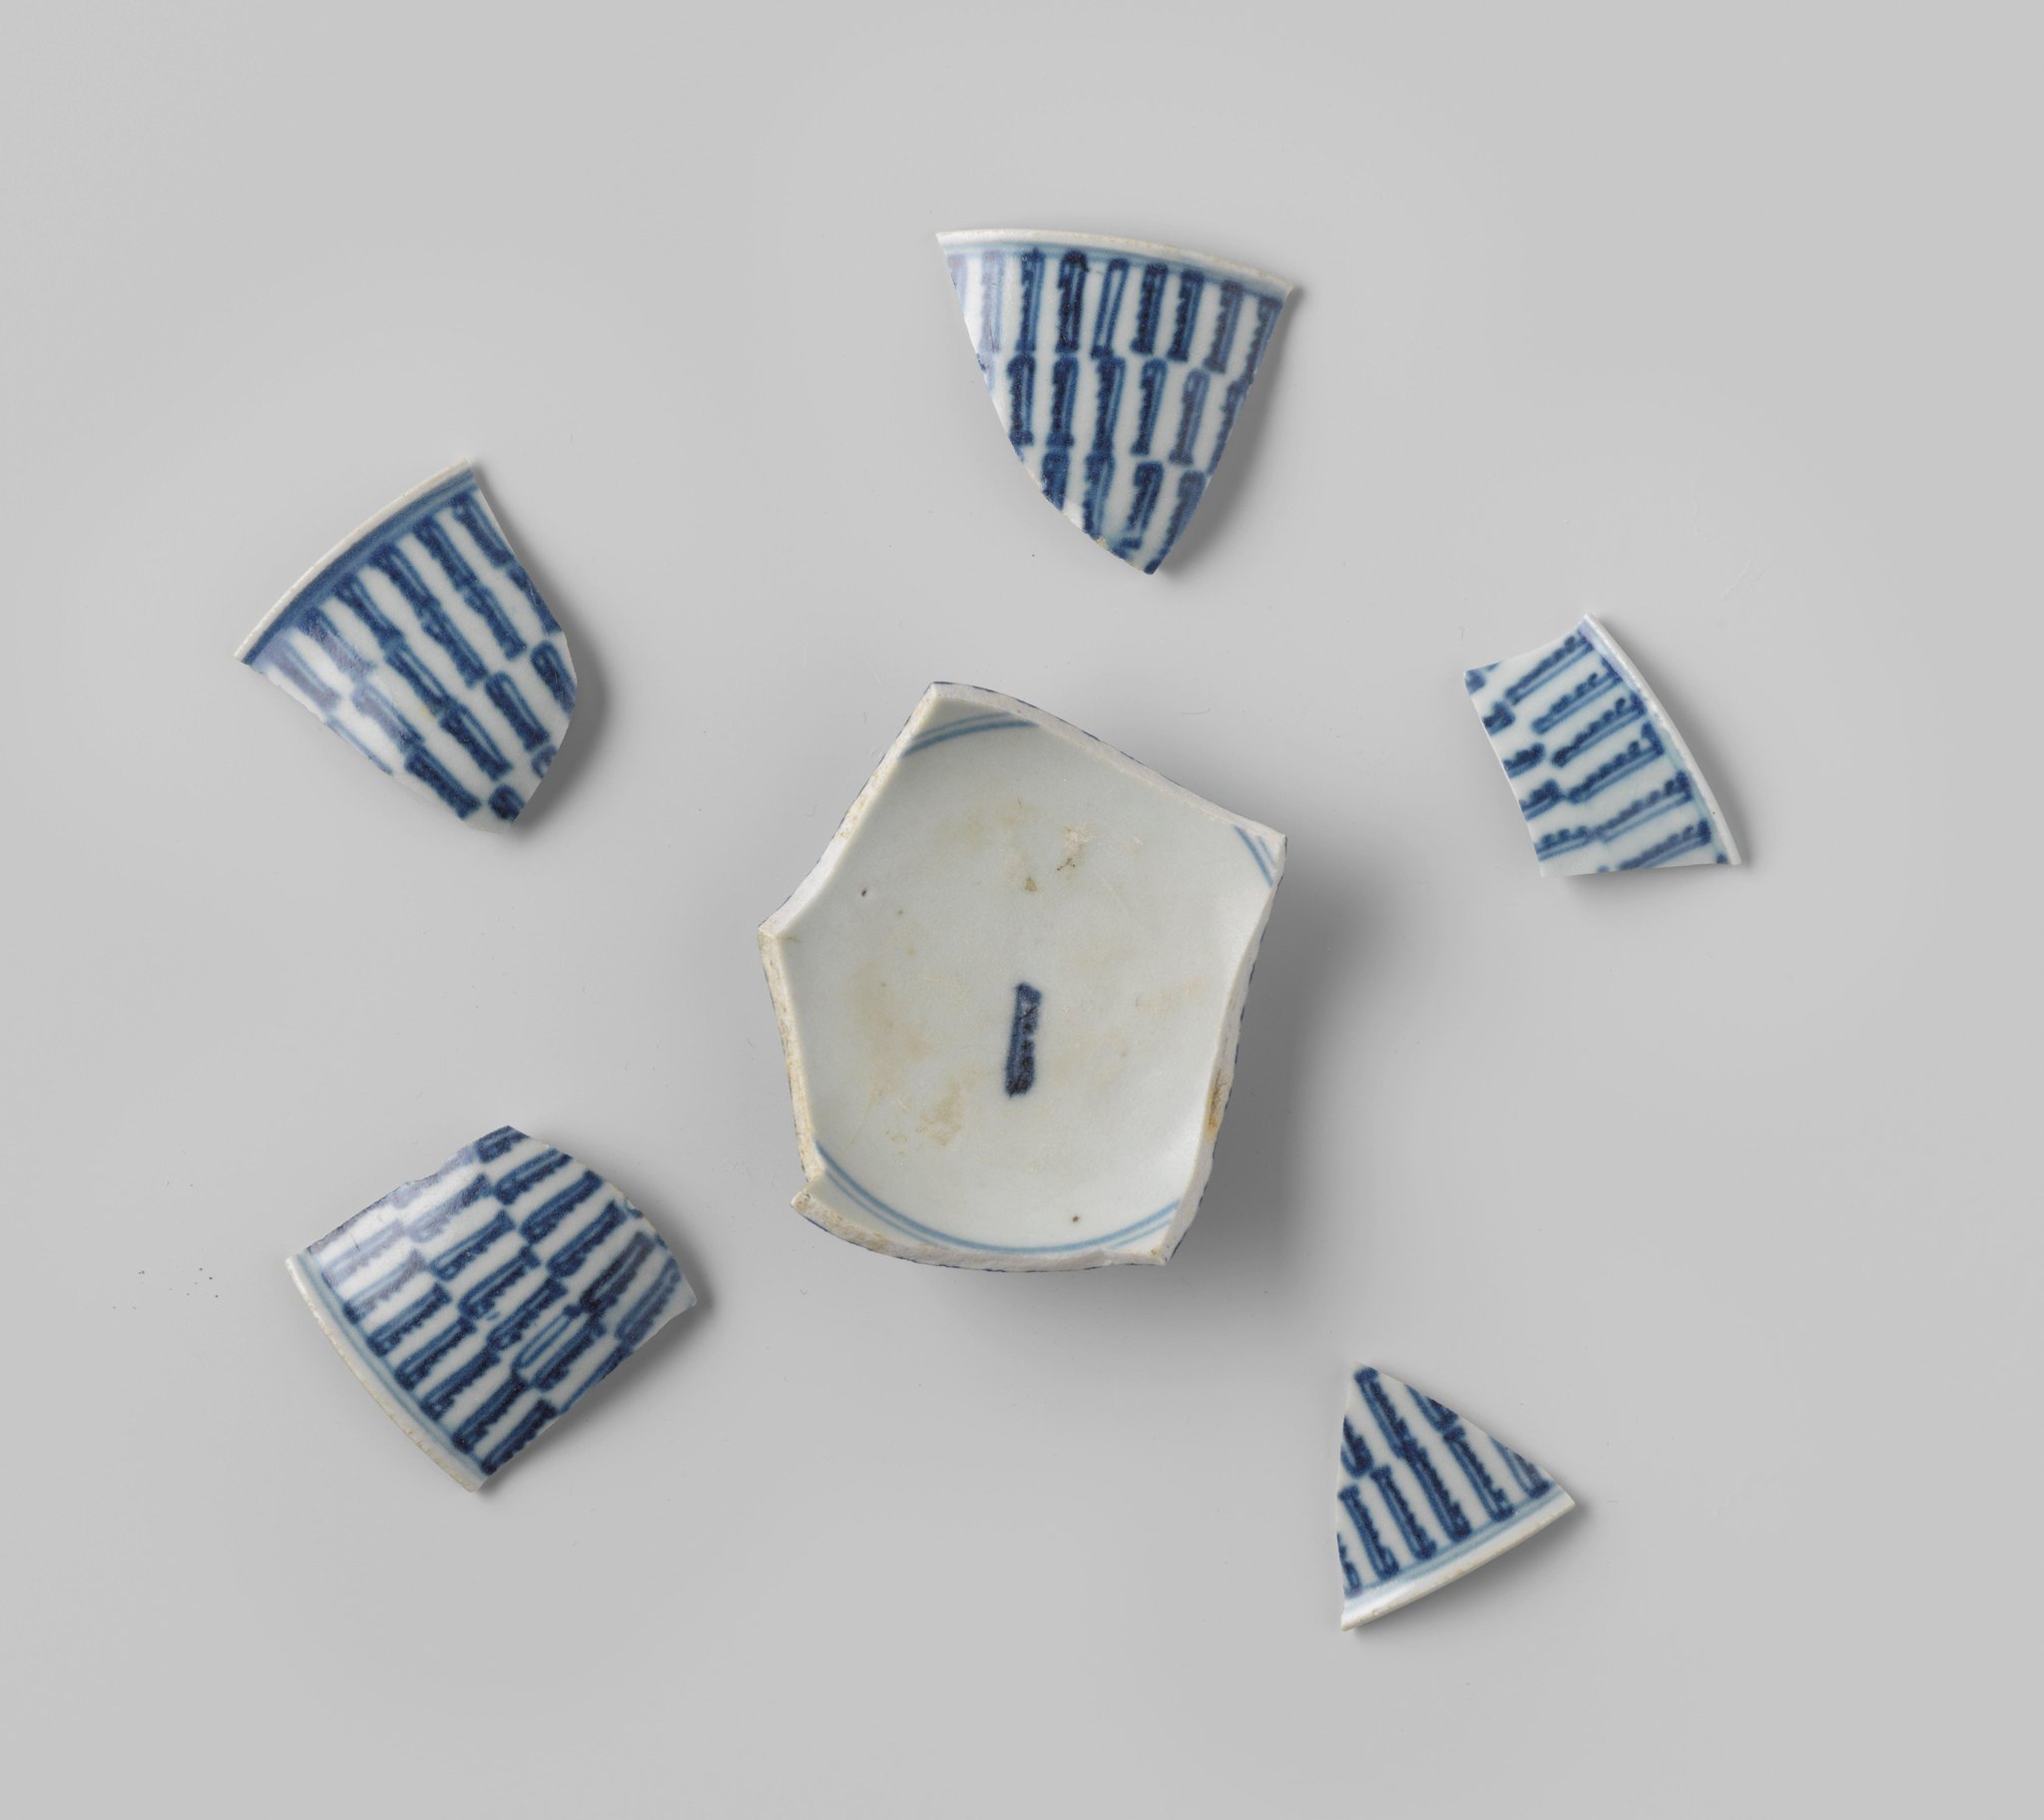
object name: bowl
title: Scherven van een kom uit V.O.C.-schip de 'Witte Leeuw'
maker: Anonymous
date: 1613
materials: porcelain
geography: jingdezhen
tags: verenigde oostindische compagnie, sint-helena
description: A bowl with a comb motive.In the centre a single comb motive is drawn surrounded by a double band. On the outside four layers with comb design.